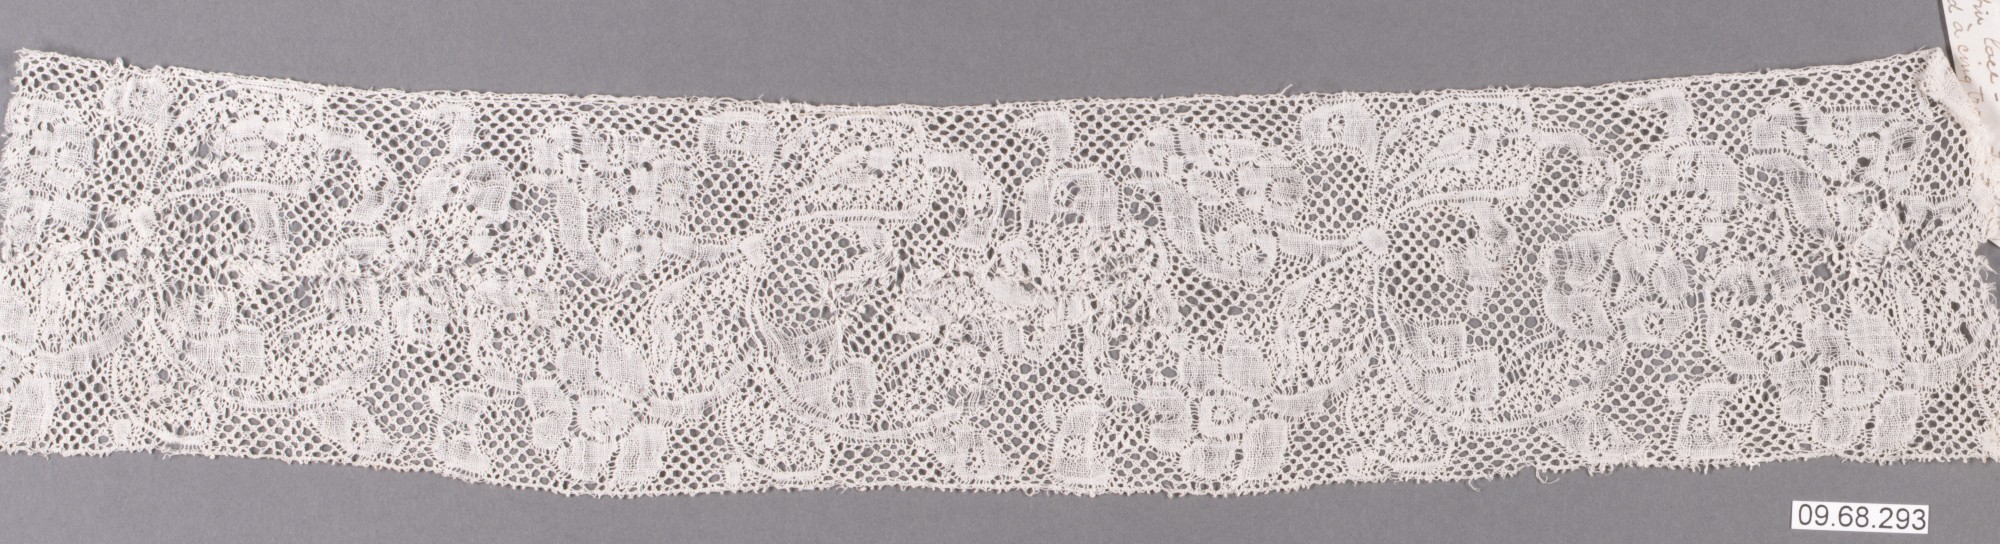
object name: piece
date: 1701-1800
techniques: lace